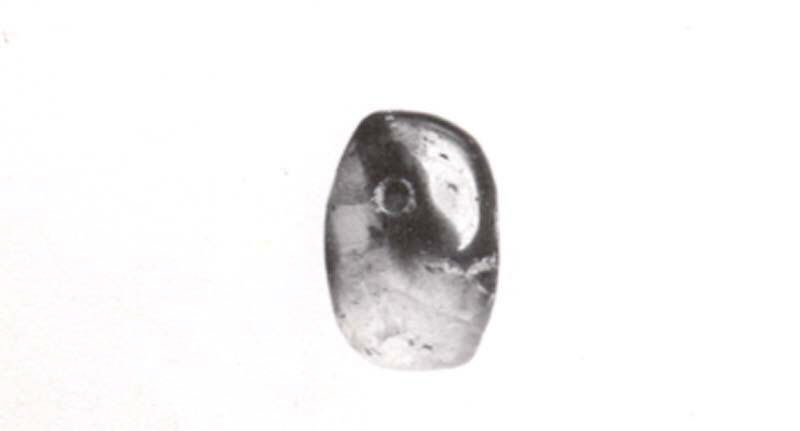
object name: bead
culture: sasanian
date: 201-700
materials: gemstone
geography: iran